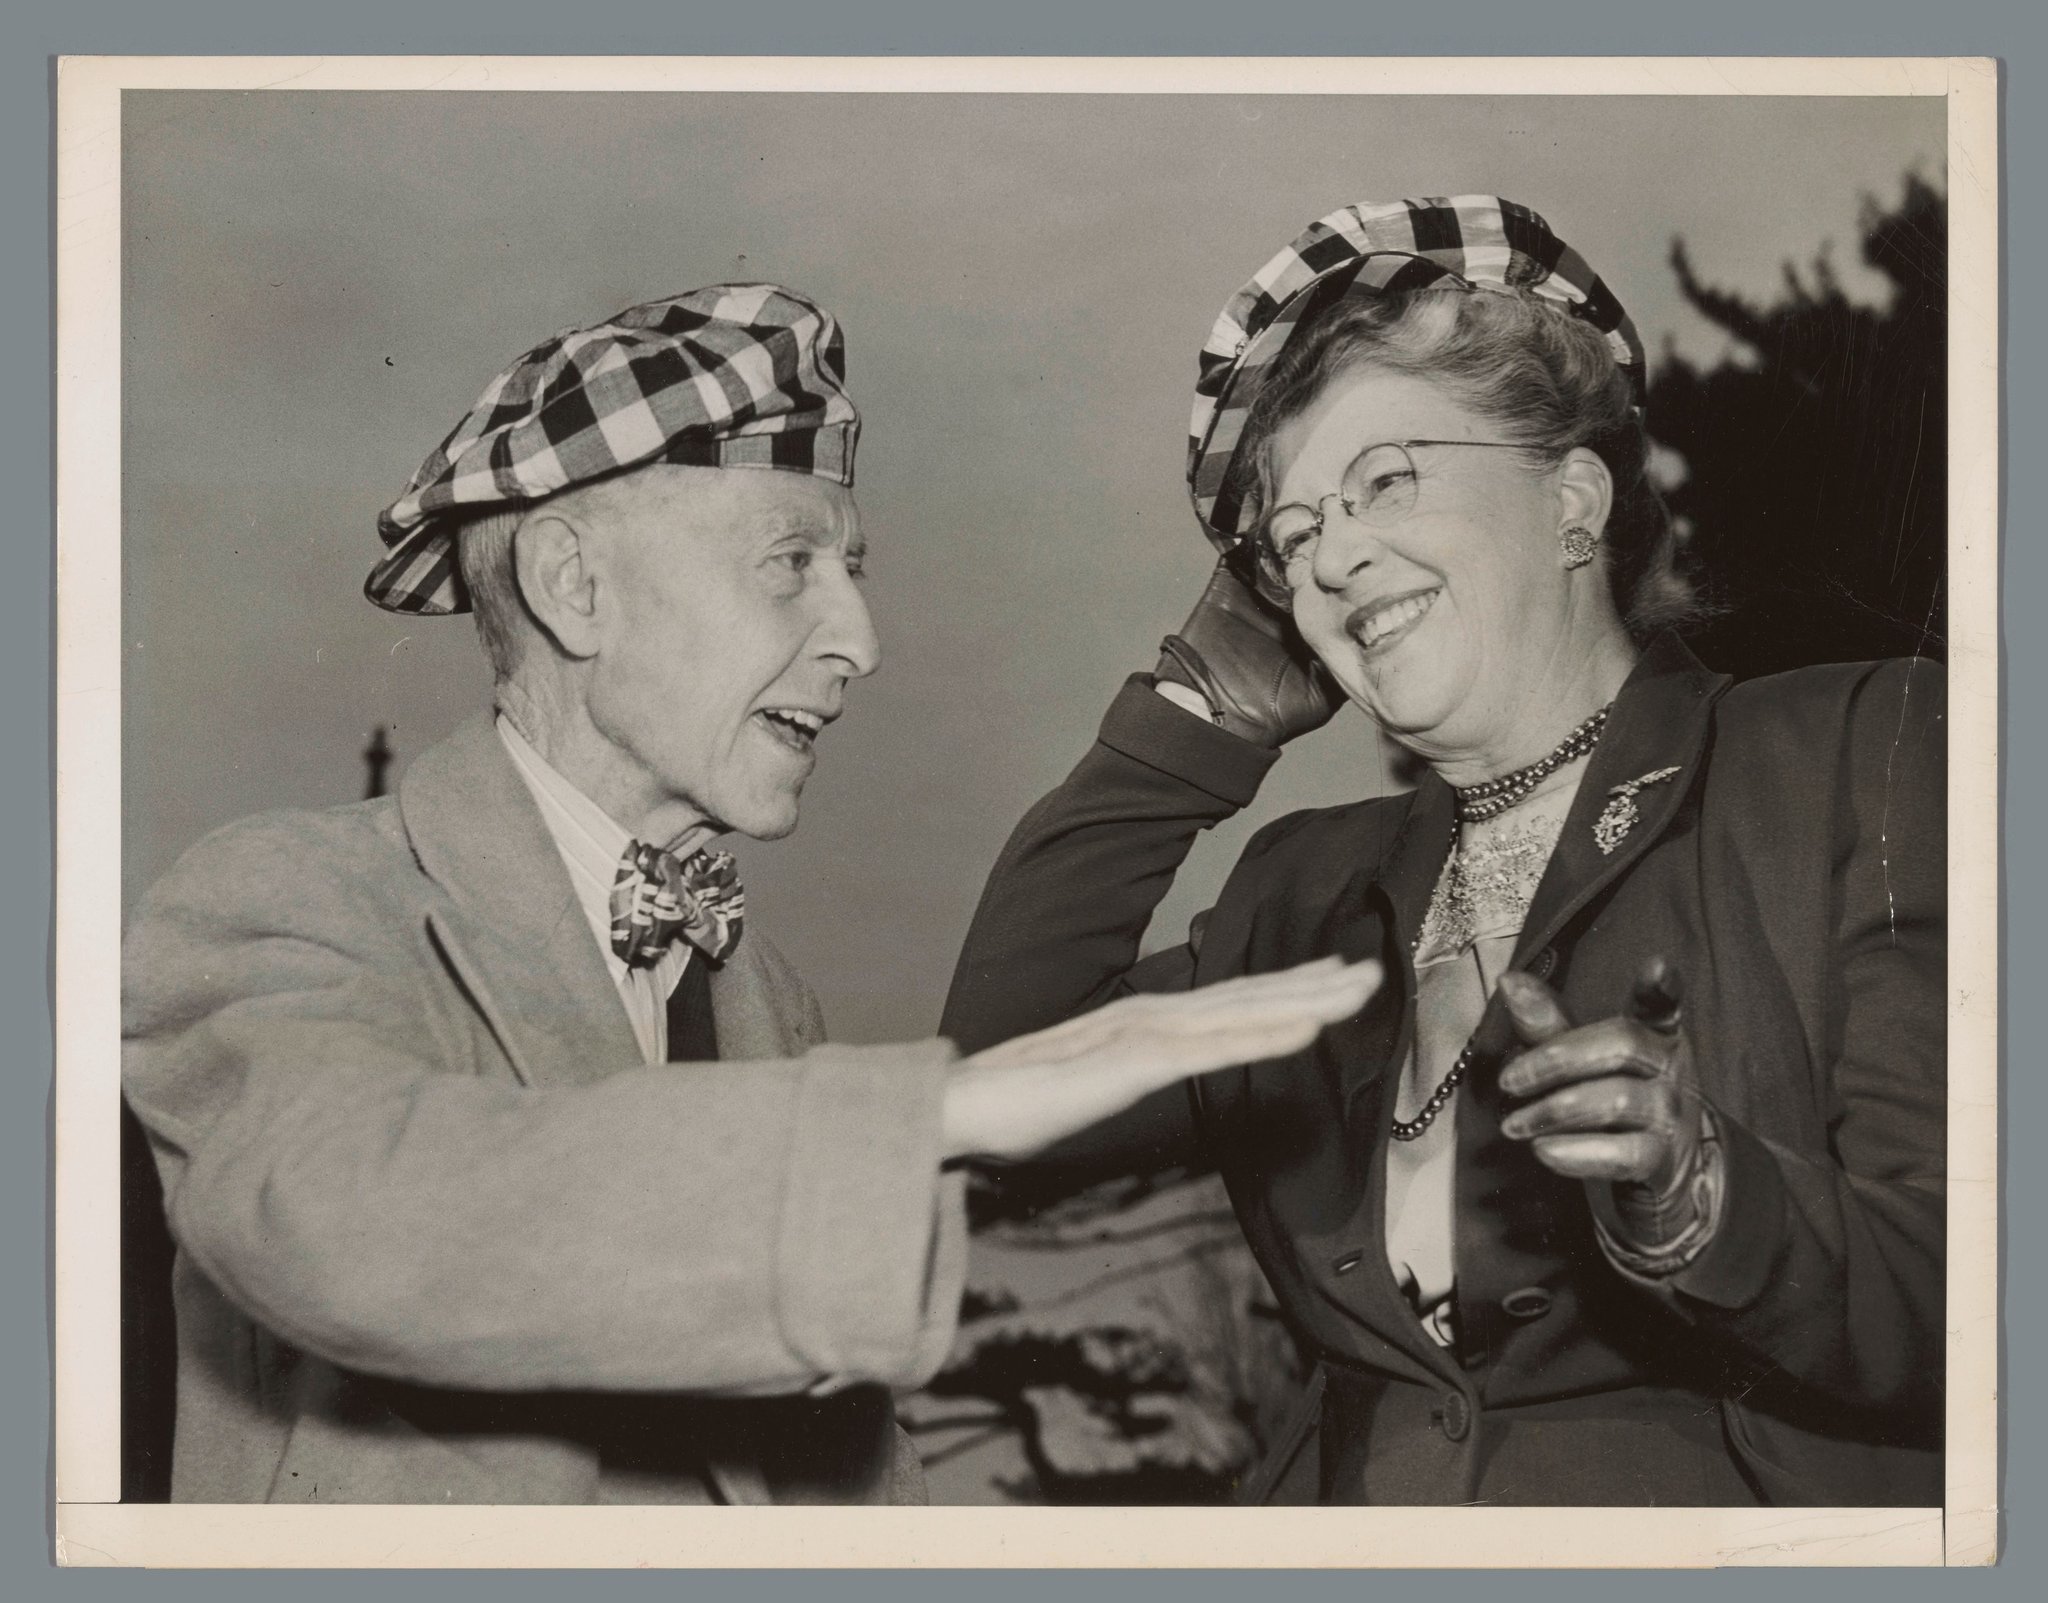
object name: photograph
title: Portret van piloot G. F. Myers en pilote Ruth Law Oliver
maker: Anonymous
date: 1948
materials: photographic support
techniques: gelatin silver print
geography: washington d.c.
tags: pilot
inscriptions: inscription: ‘International news photo a unit of king features synd. (...) the individuals appearing in it’, inscription: ‘103,486 - Watch your credit (...) 12/17/48 -NS-’